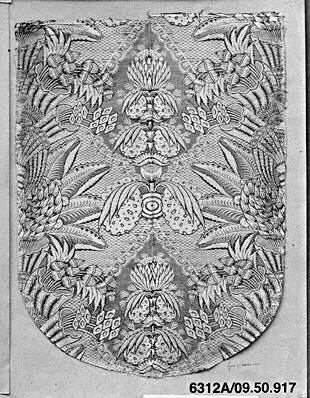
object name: piece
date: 1705-1710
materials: silk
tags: flowers,leaves